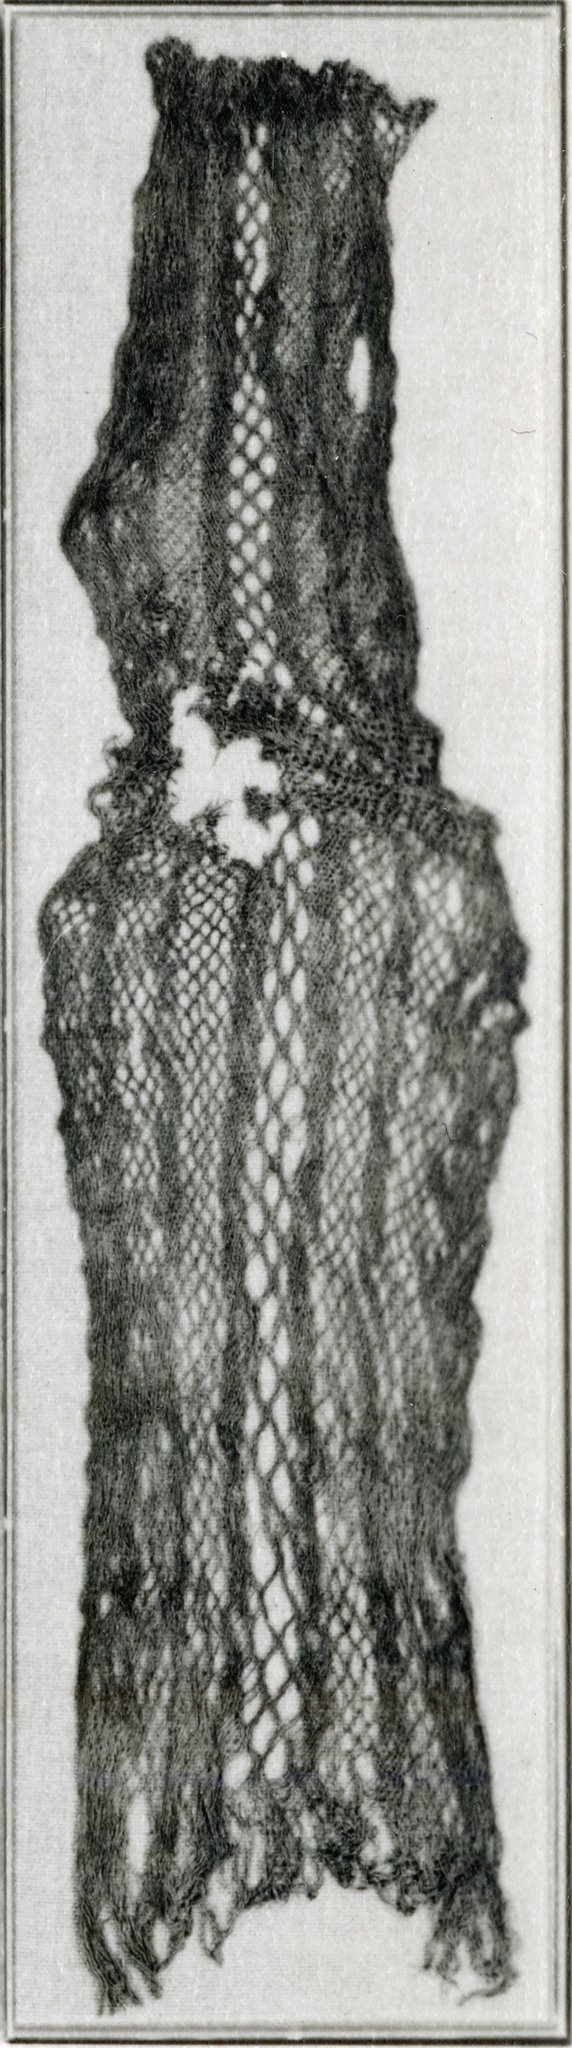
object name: veil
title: Veil (?)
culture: coptic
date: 301-400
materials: linen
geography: egypt